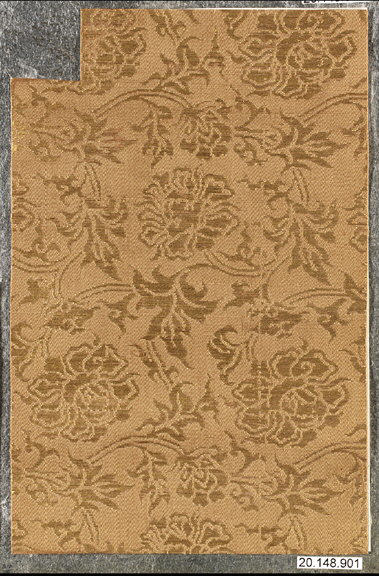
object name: textile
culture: china or japan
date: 1701-1800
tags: flowers